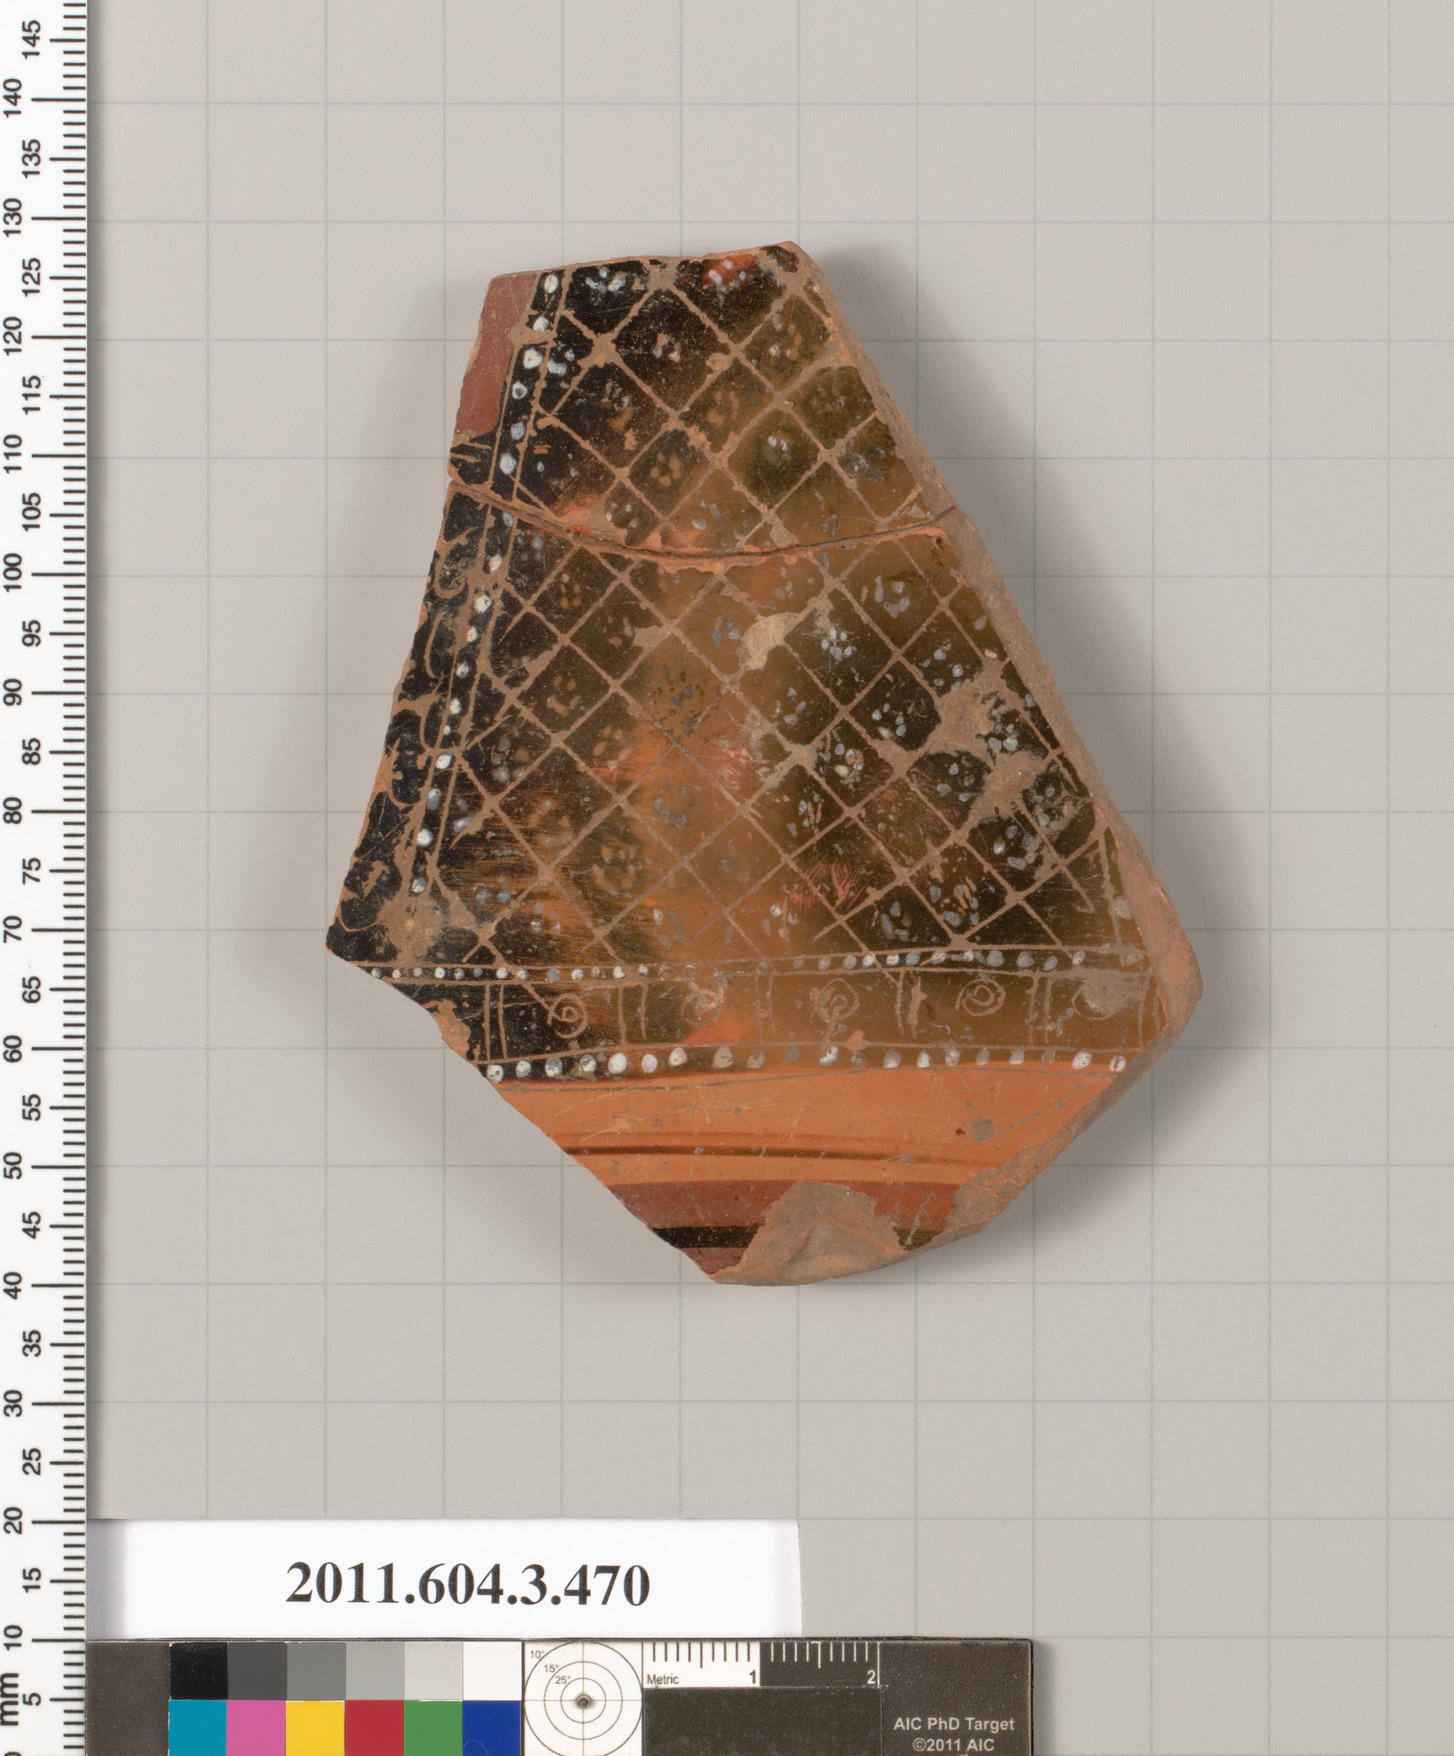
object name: panathenaic prize amphora fragment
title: Terracotta fragment of a Panathenaic prize amphora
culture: greek, attic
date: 550-526 BCE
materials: terracotta